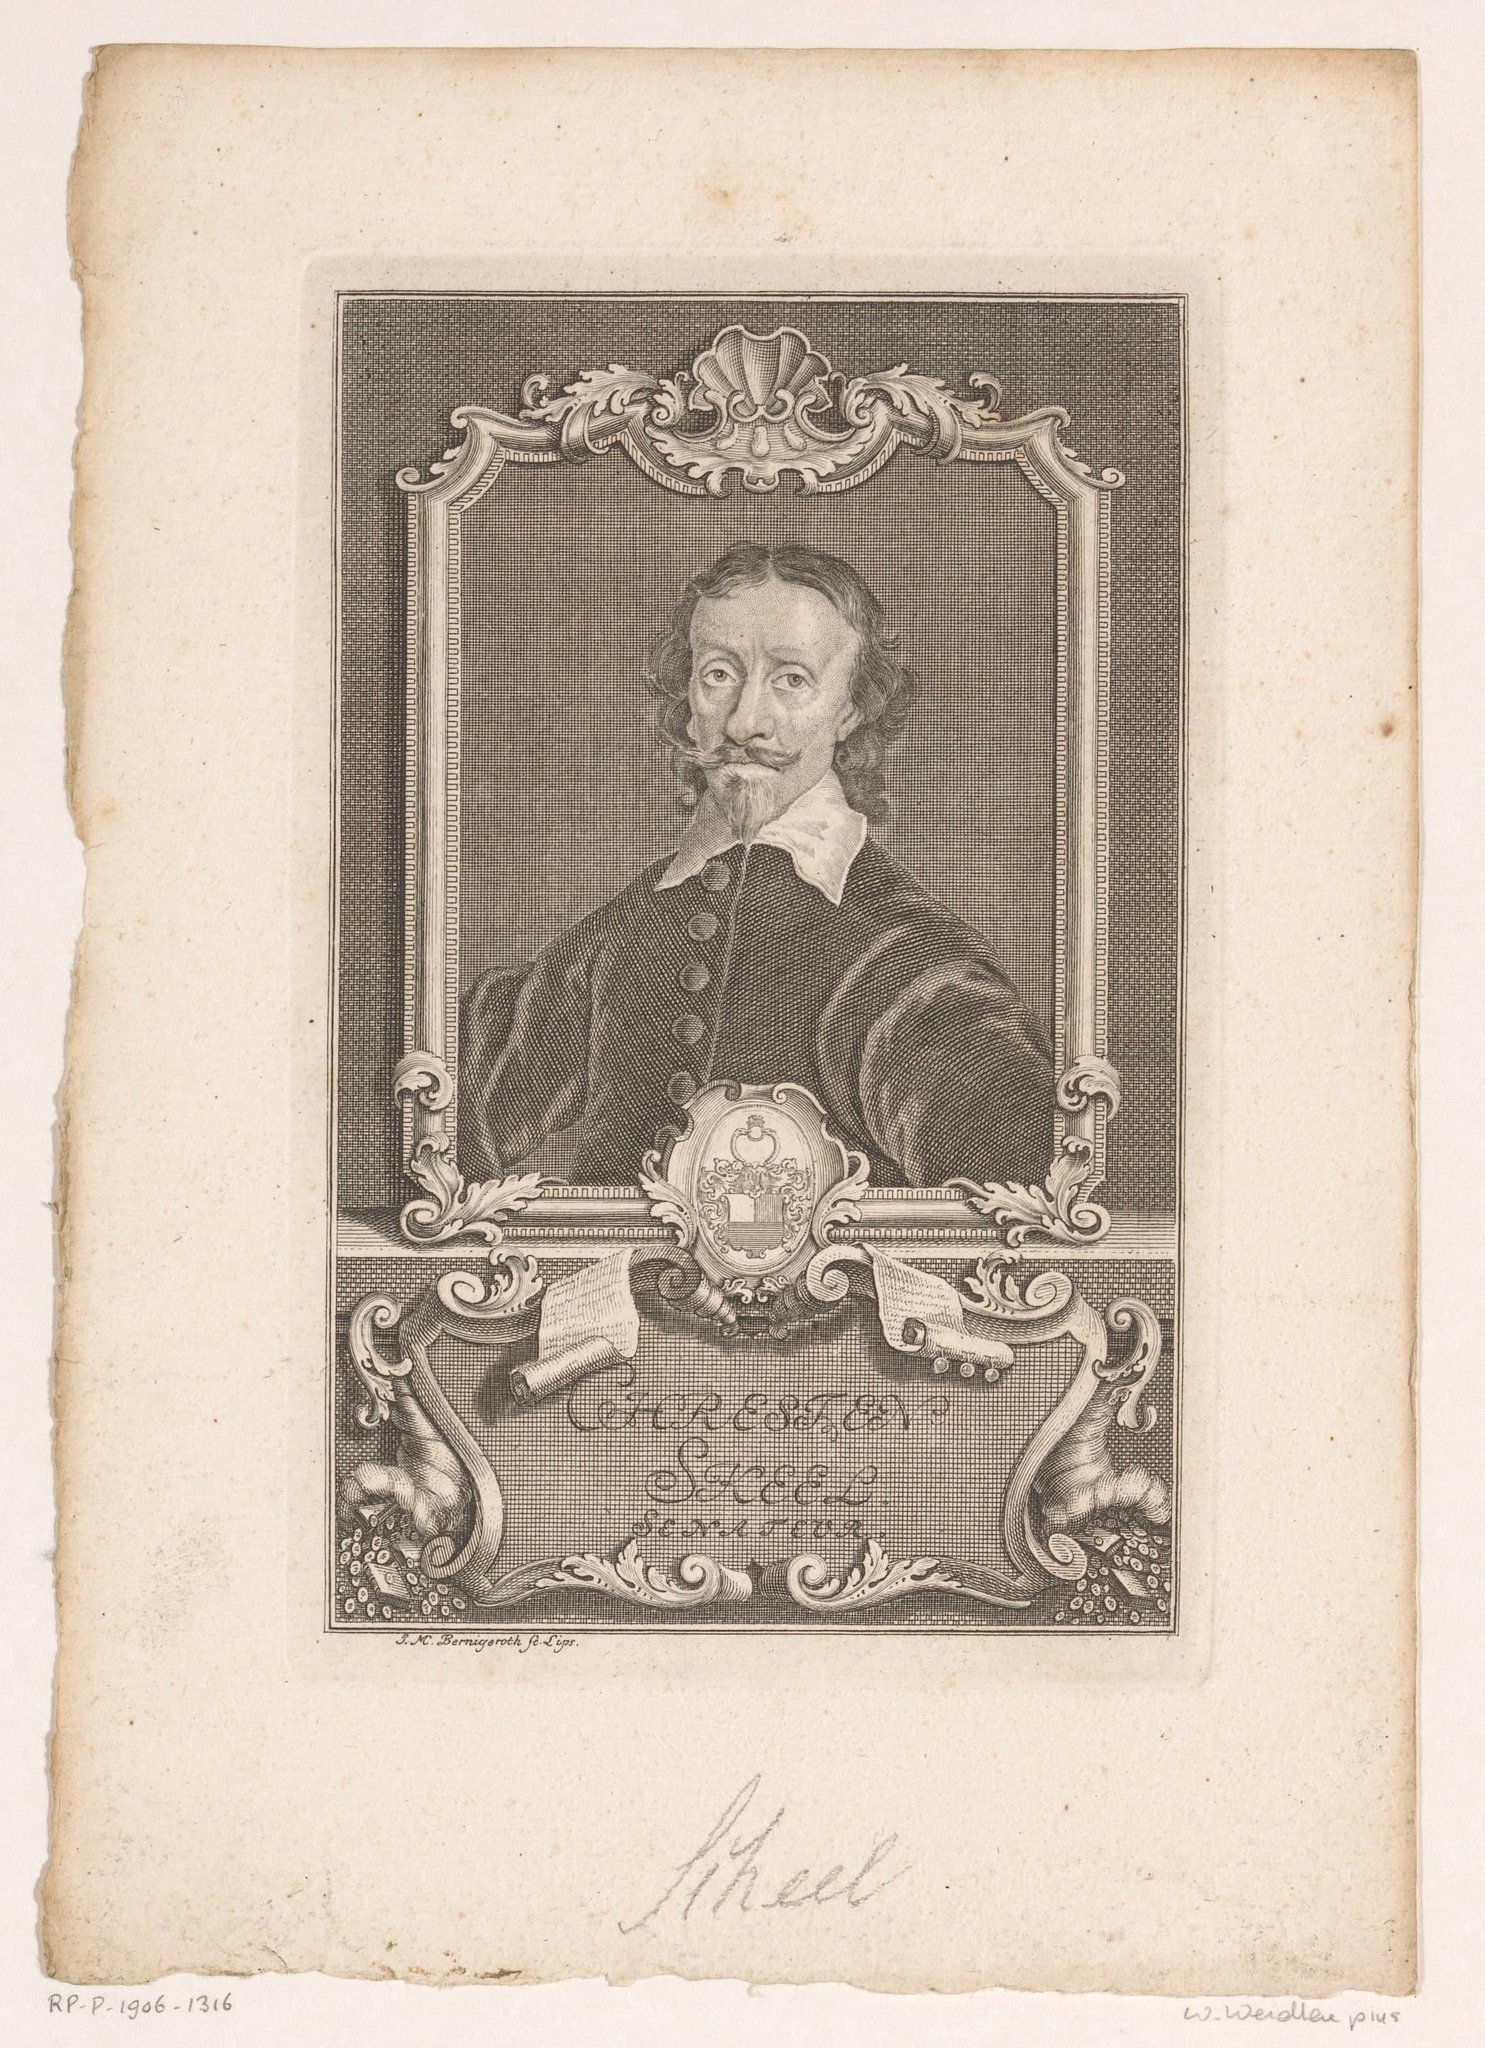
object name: print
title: Portret van Christen Skeel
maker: johann martin bernigeroth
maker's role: print maker, publisher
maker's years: 1713-1767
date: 1723-1767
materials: paper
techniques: engraving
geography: leipzig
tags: politician, 'cornucopia', horn of plenty, historical persons, handwriting, written text, armorial bearing, heraldry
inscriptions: collector's mark: Lugt 2228